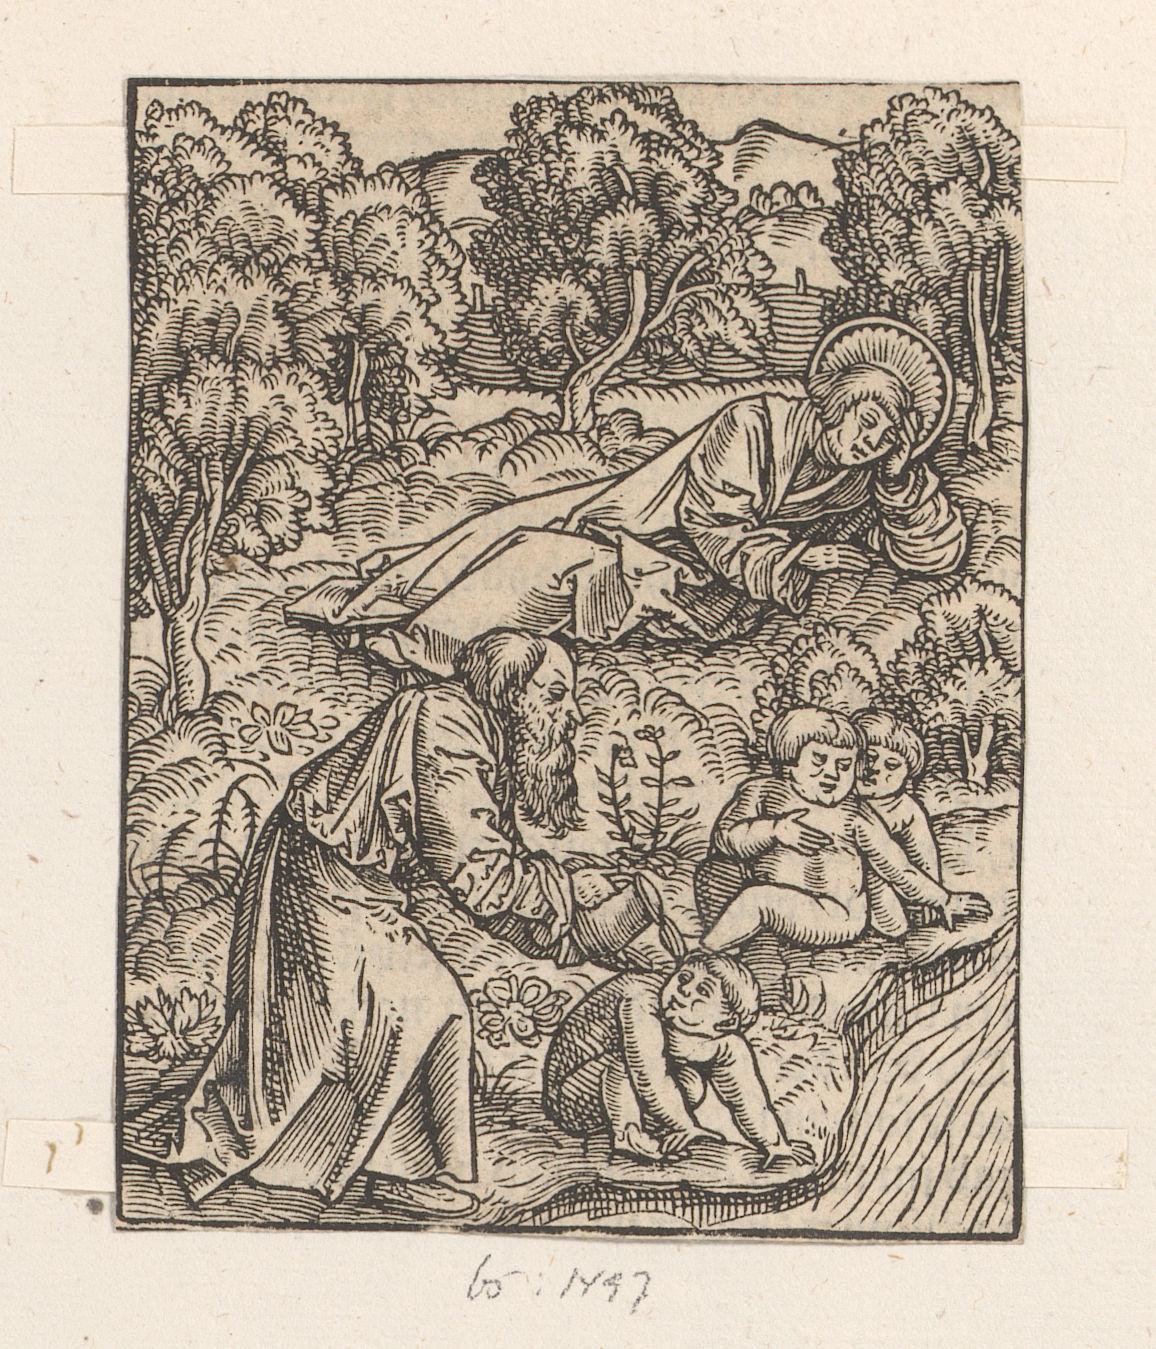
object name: album leaf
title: Leven van de heilige Brigitta van Zweden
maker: Anonymous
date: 1500-1600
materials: paper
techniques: woodcut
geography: germany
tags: the foundress of the order of bri(d)gettines, the widow bridget (birgitta) of sweden; possible attributes: band over veil with five red spots, book, candle, heart with cross, inkhorn, pilgrim's hat, staff, wallet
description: Een heilige slaapt in een landschap. Op de voorgrond een man gekleed in een pij met een kan in zijn hand. Bij een stroom water drie kinderen. Prent maakt deel uit van een album.